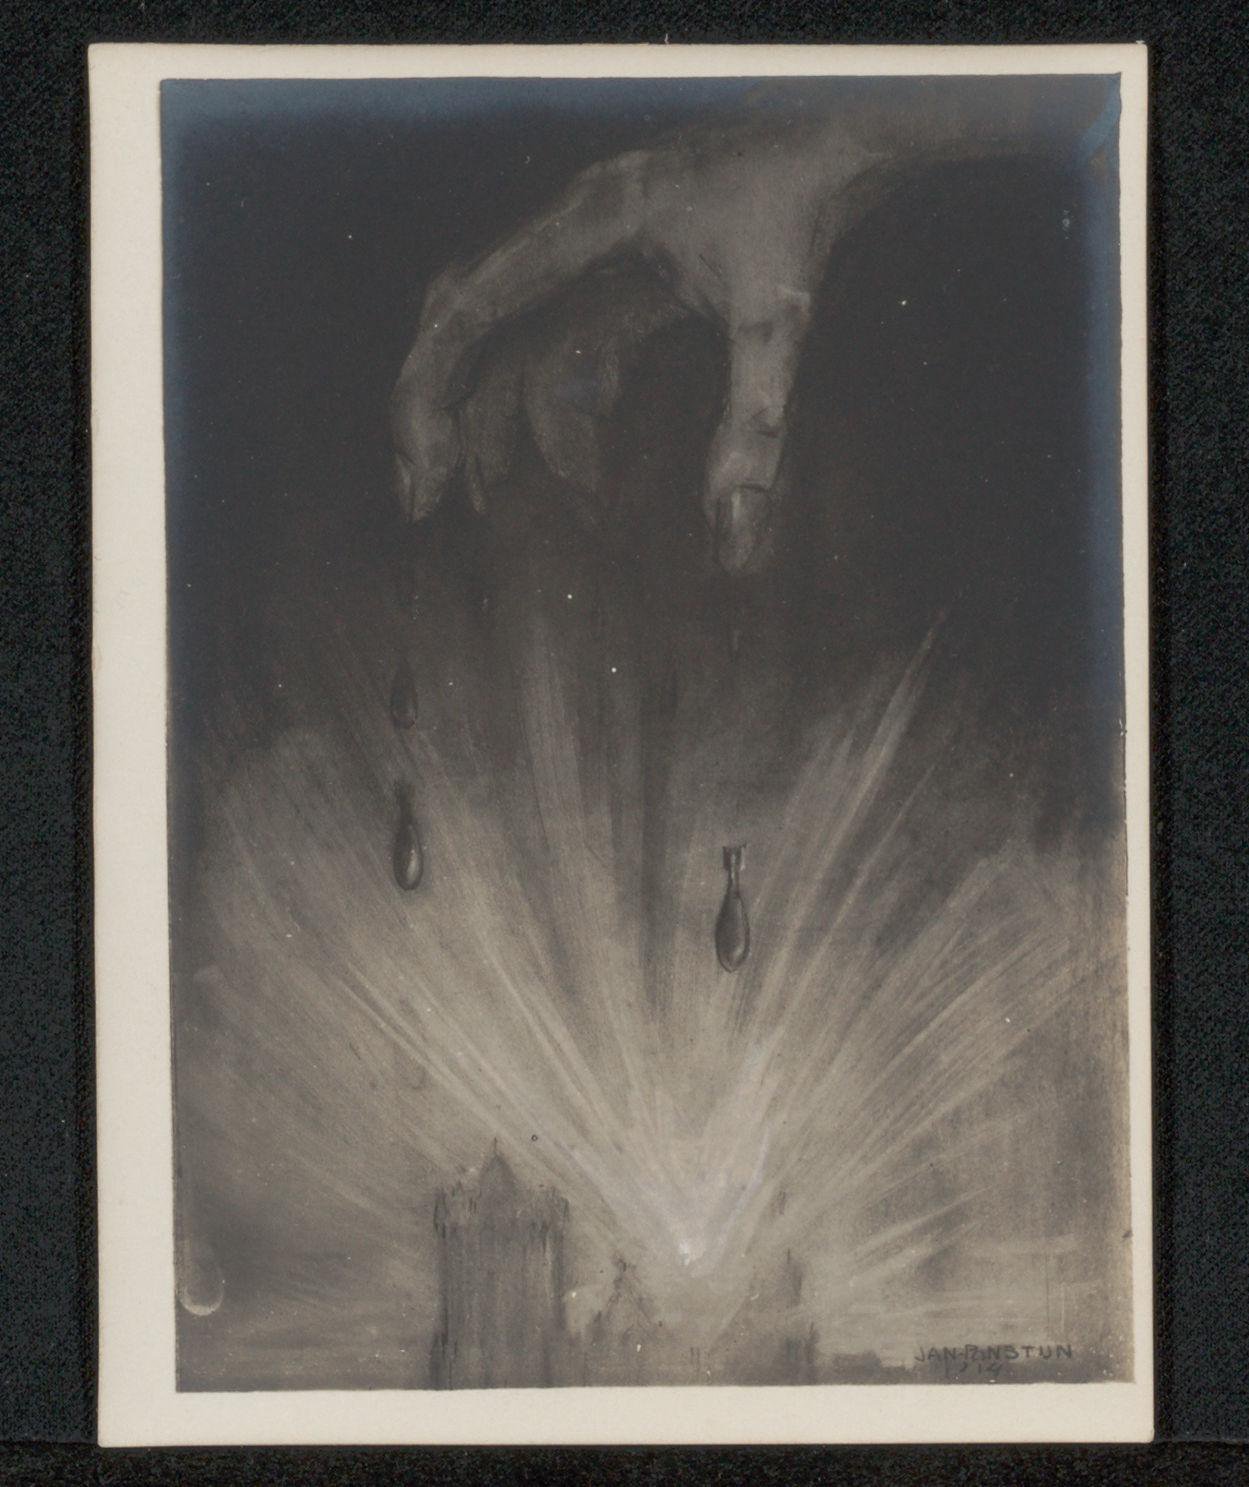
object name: photograph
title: Foto uit archief Philip Zilcken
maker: Anonymous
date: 1914-1930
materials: photographic support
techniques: gelatin silver print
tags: the hague, painter, philip zilcken, hand, church (exterior), projectiles, explosives, etc.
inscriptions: collector's mark: ‘RPK’